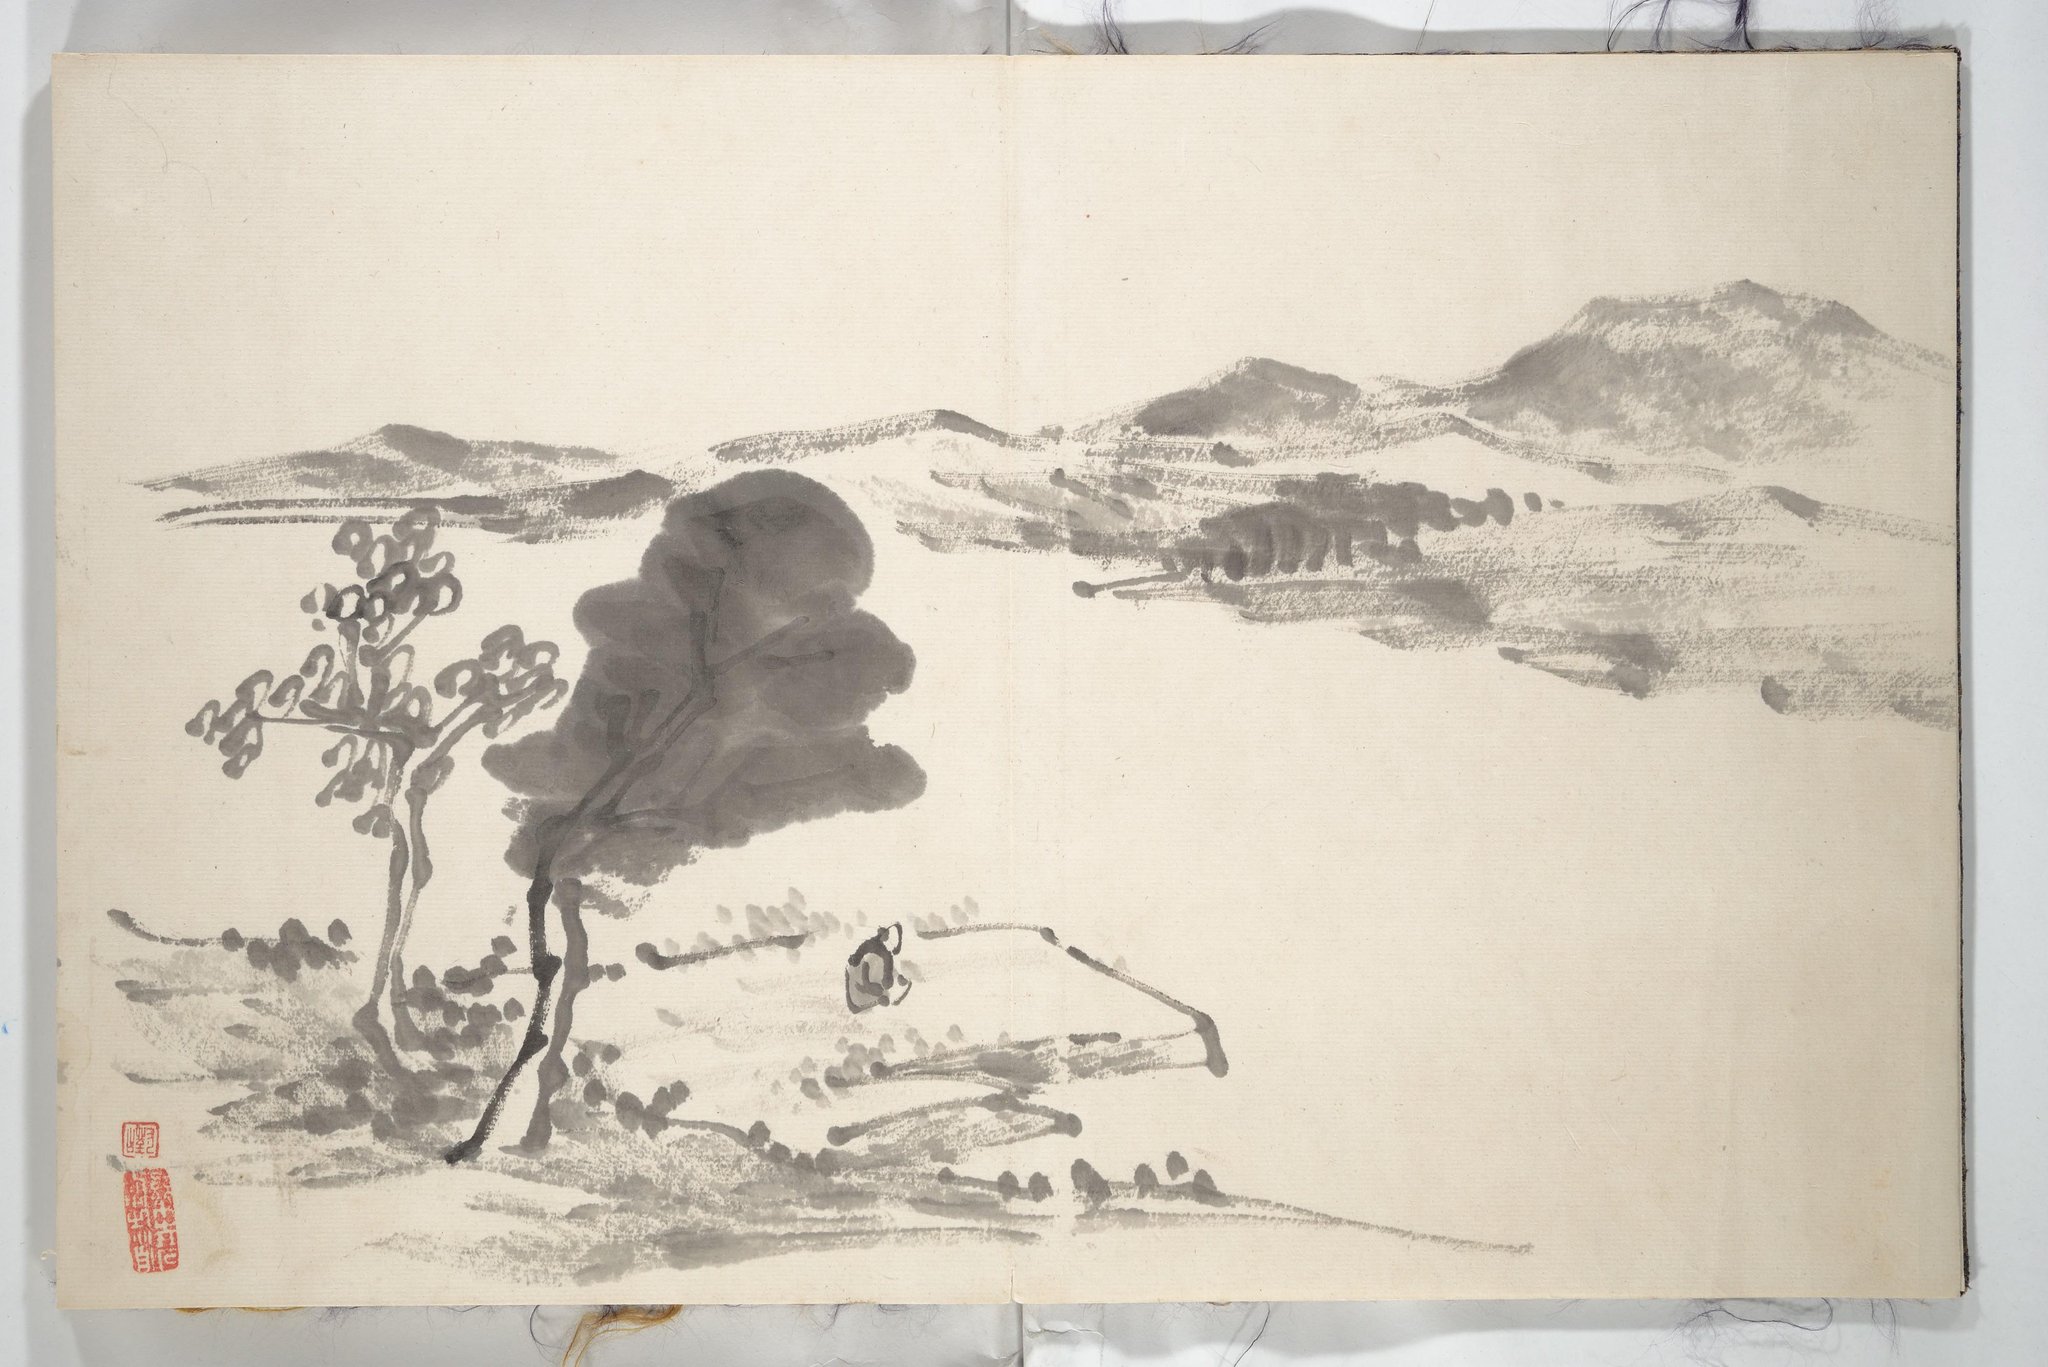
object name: illustrated book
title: Untitled Picture Album of Fifteen Ink Paintings 對山先生山水画譜(たいざん せんせい さんすいがふ)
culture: japanese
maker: hine taizan 日根對山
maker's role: artist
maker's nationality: japanese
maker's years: 1813-1869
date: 1850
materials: ink, paper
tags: landscapes,trees